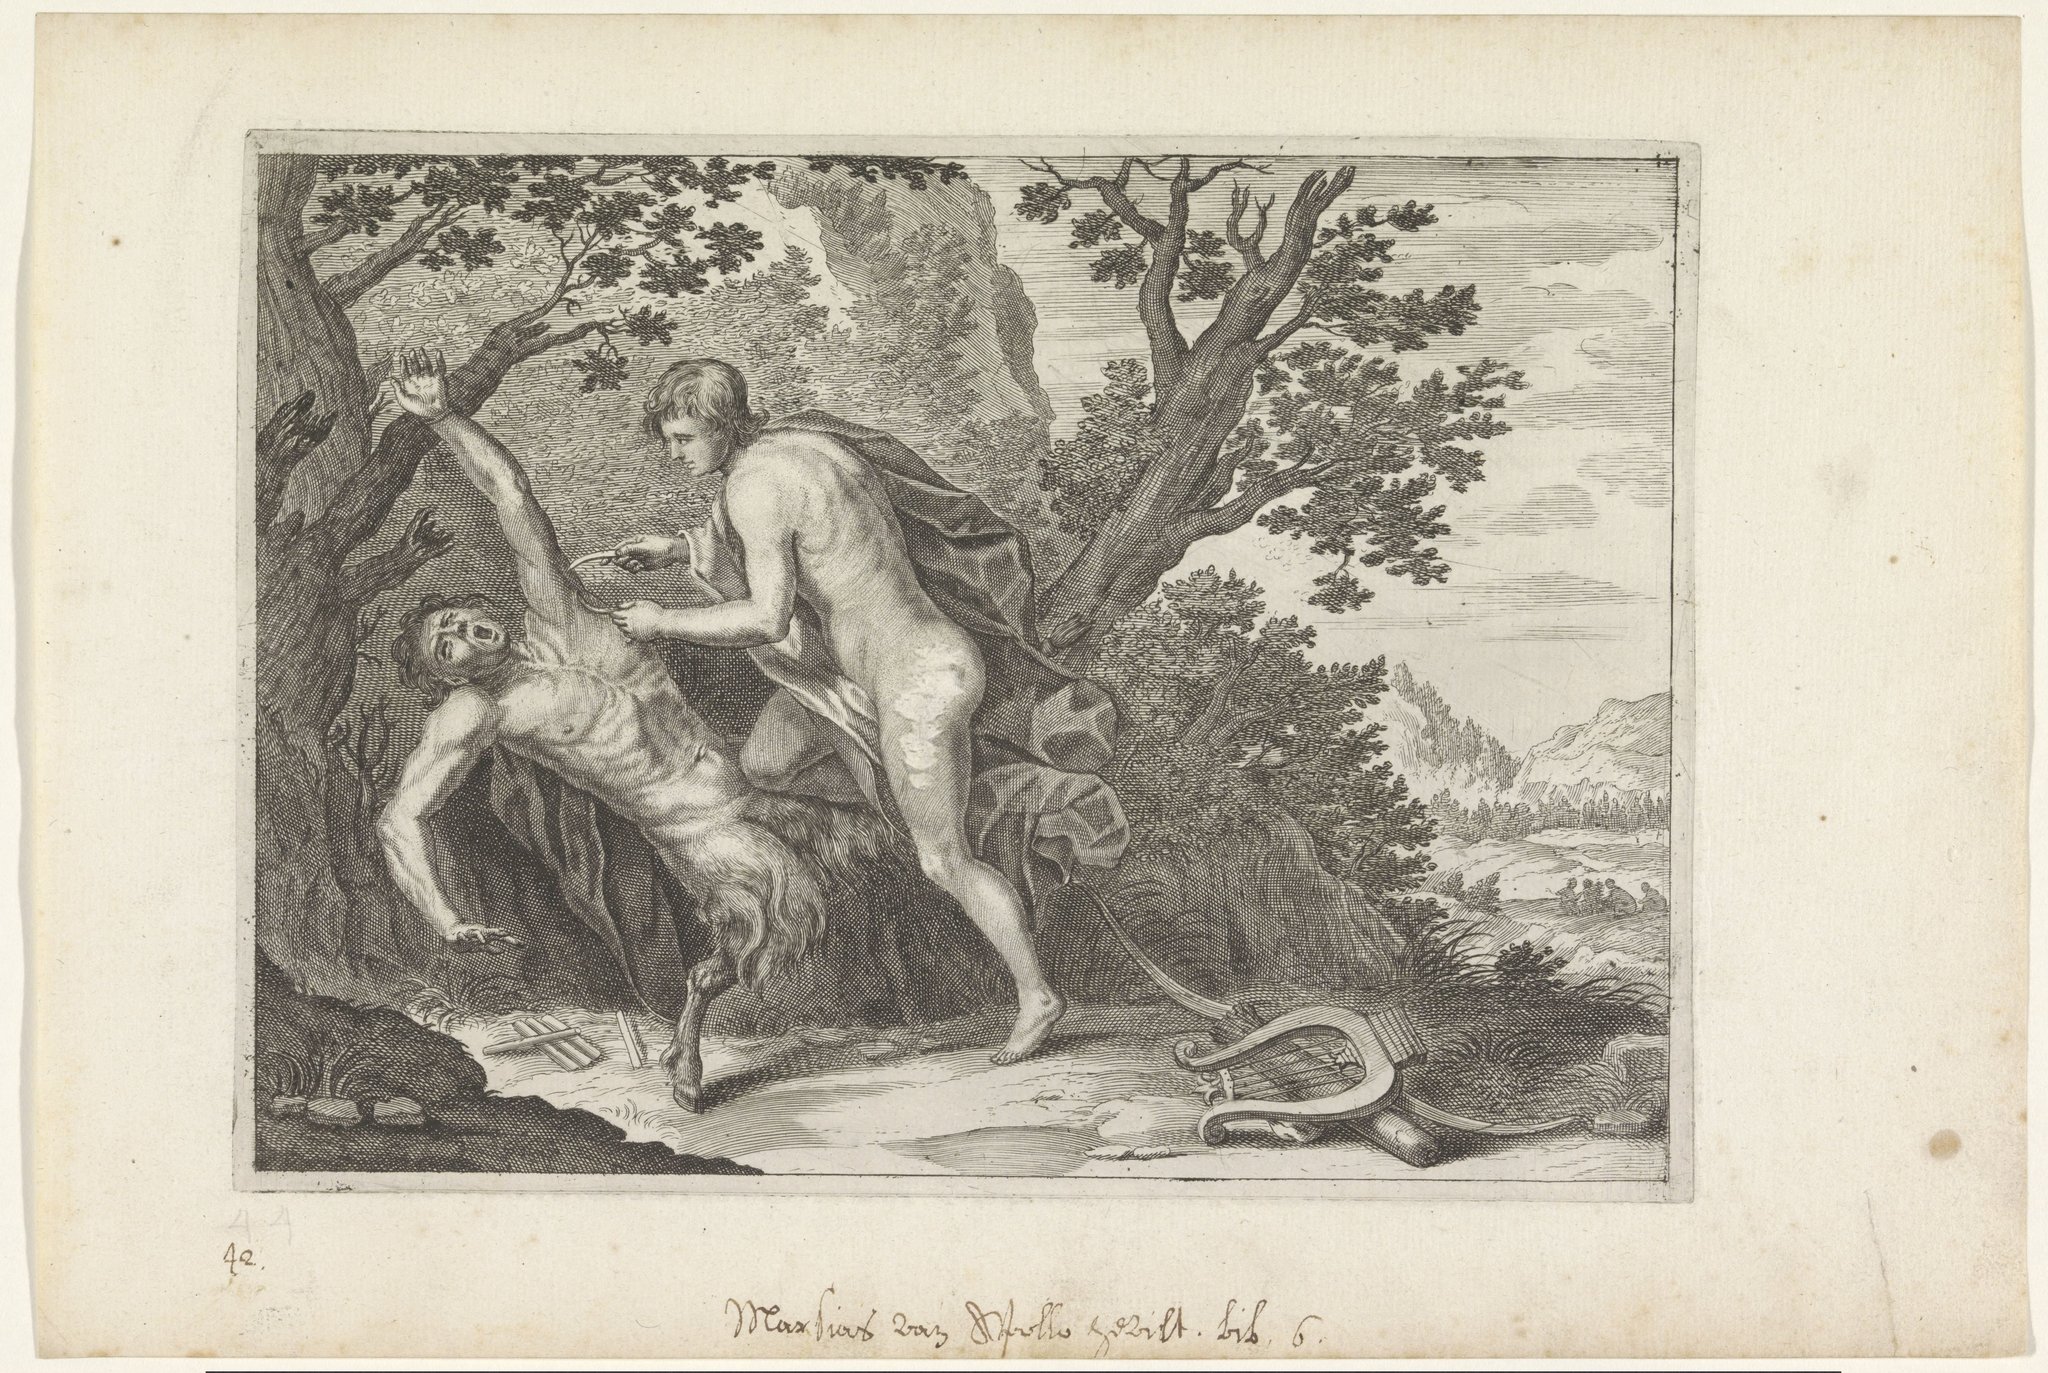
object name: print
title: Apollo vilt Marsyas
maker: crispijn van de passe (ii)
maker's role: draughtsman, print maker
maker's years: 1594-1670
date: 1636-1670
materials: paper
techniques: engraving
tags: punishment of marsyas: he is flayed by apollo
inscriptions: collector's mark: ‘Hinloopen’, number: ‘42’, annotation: ‘Marsias van Apollo gevilt. lib. 6.’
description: Het schilderij van Reni bevindt zich in de collectie van de Alte Pinakothek te München. Deze incomplete serie, bestaande uit 77 van de in totaal 85 prenten met scènes uit Ovidius' Metamorfosen, werd in 1709 samen met Ovidius-illustraties van Tempesta, Goltzius en Le Pautre in één album, Schijnvoet nummer 43, ingebonden. In de negentiende eeuw werd deze band weer uit elkaar gehaald.